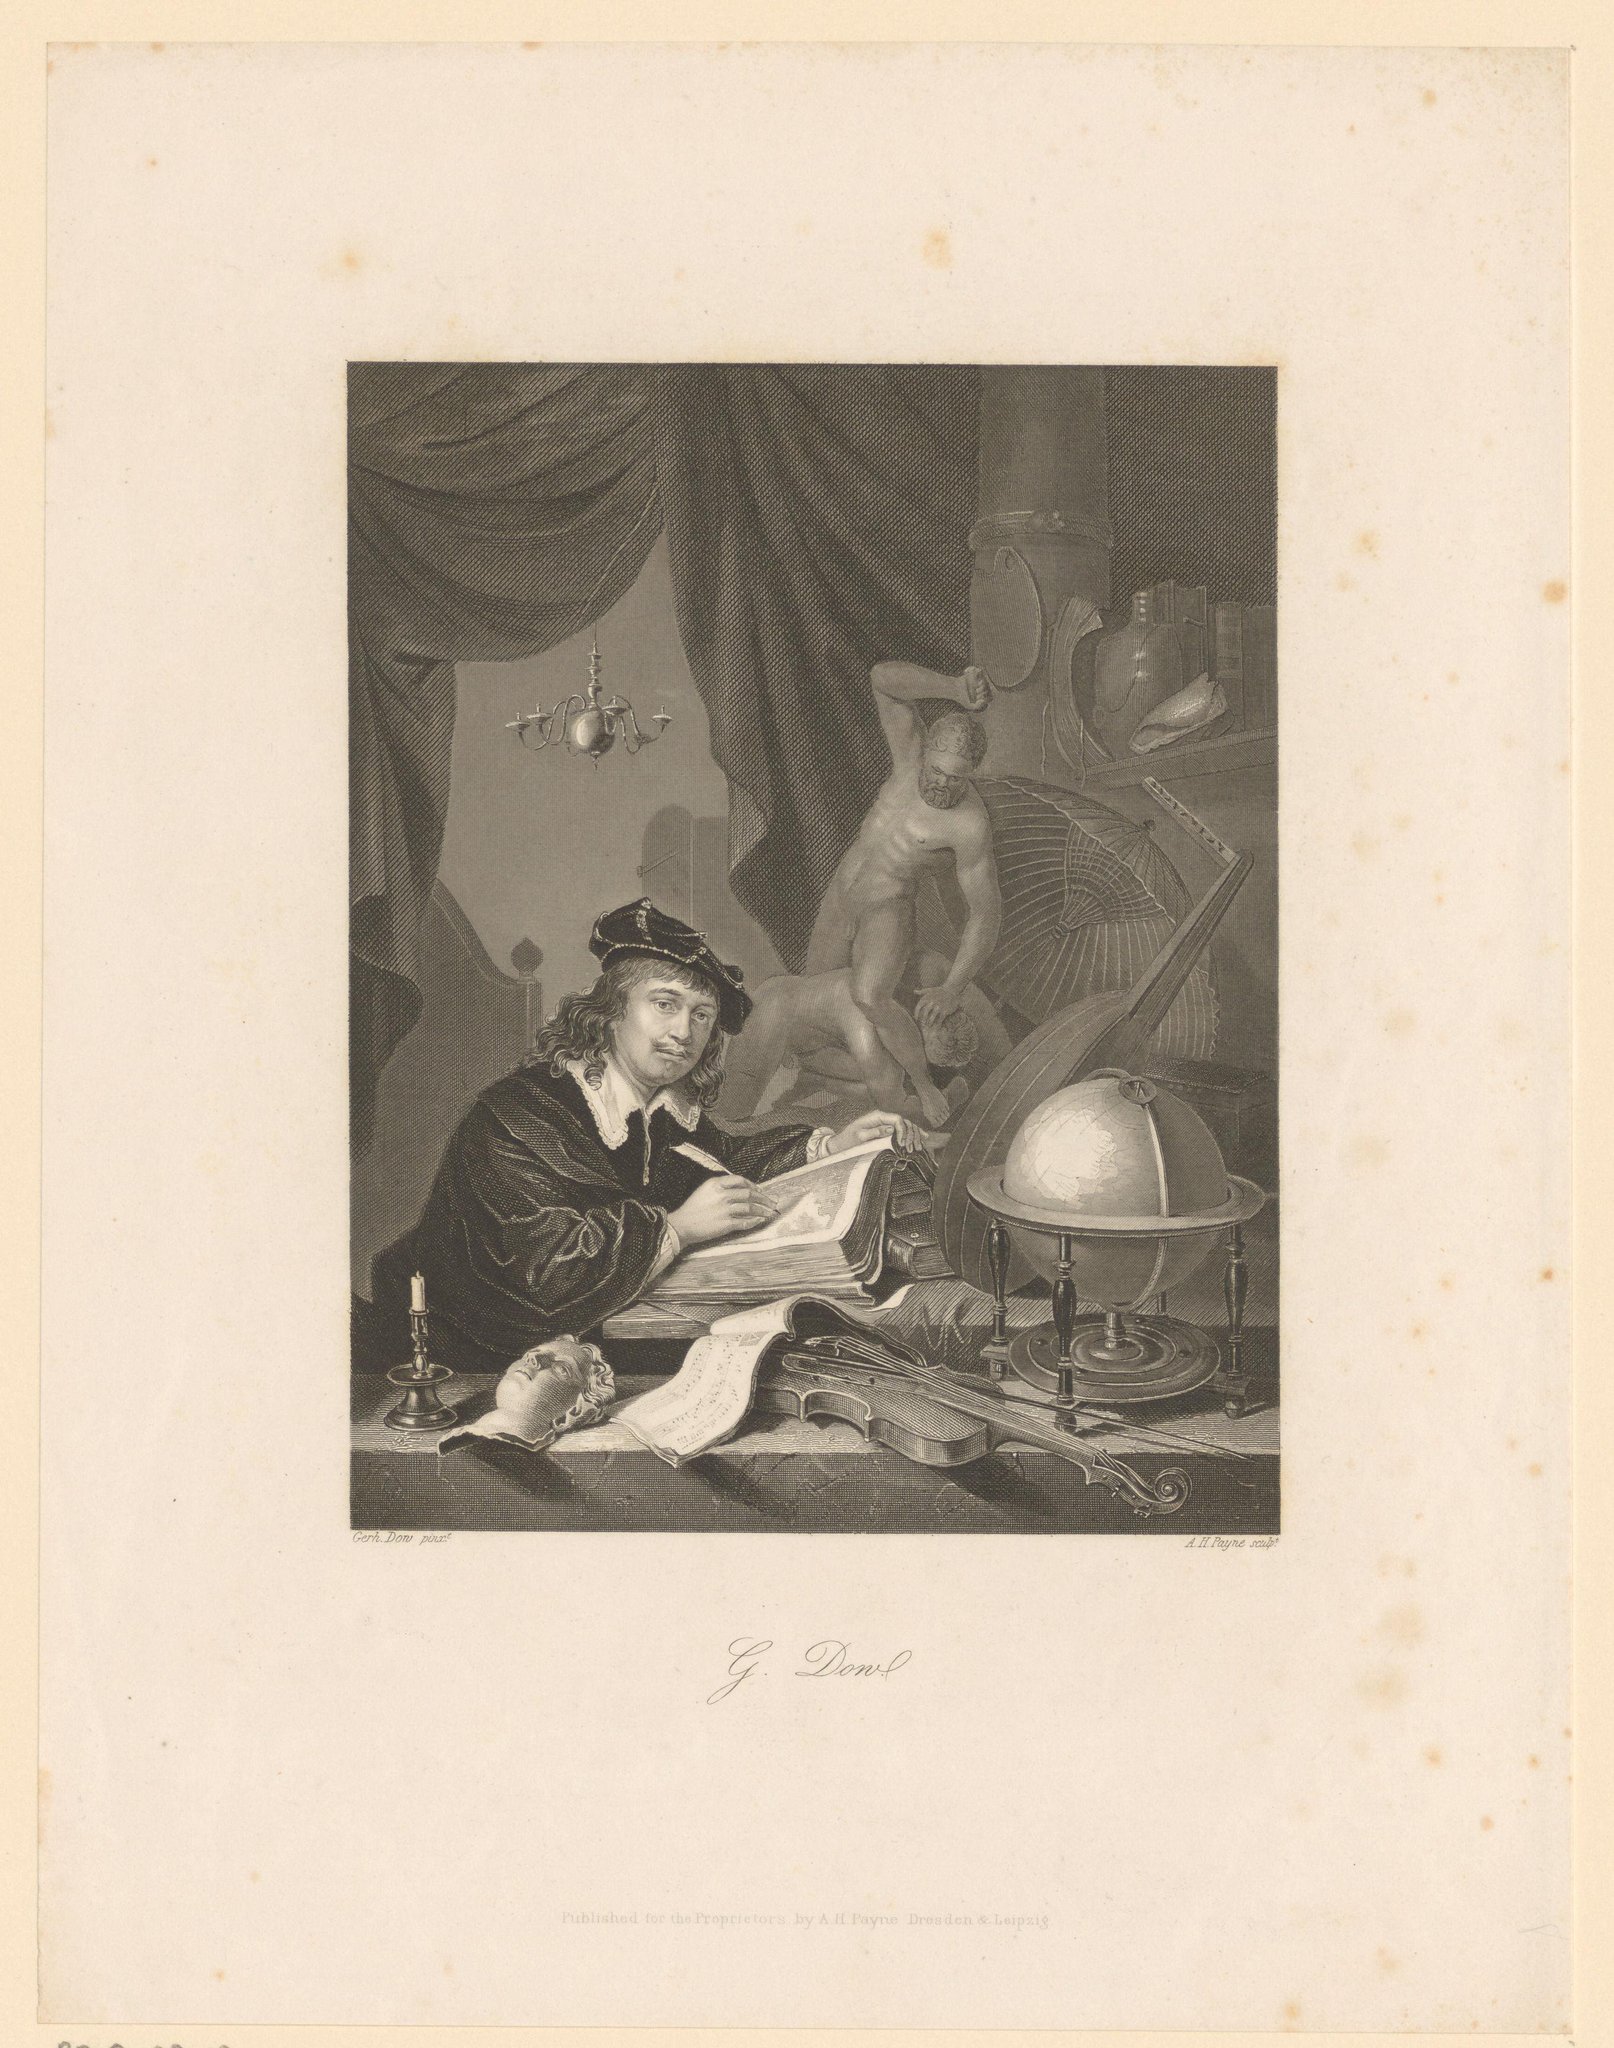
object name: print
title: G. Dow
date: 1850-1880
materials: paper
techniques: engraving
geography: dresden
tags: leiden, painter, draughtsman, gerard dou, historical persons, portrait, self-portrait of painter, study; 'studiolo'; library, globe